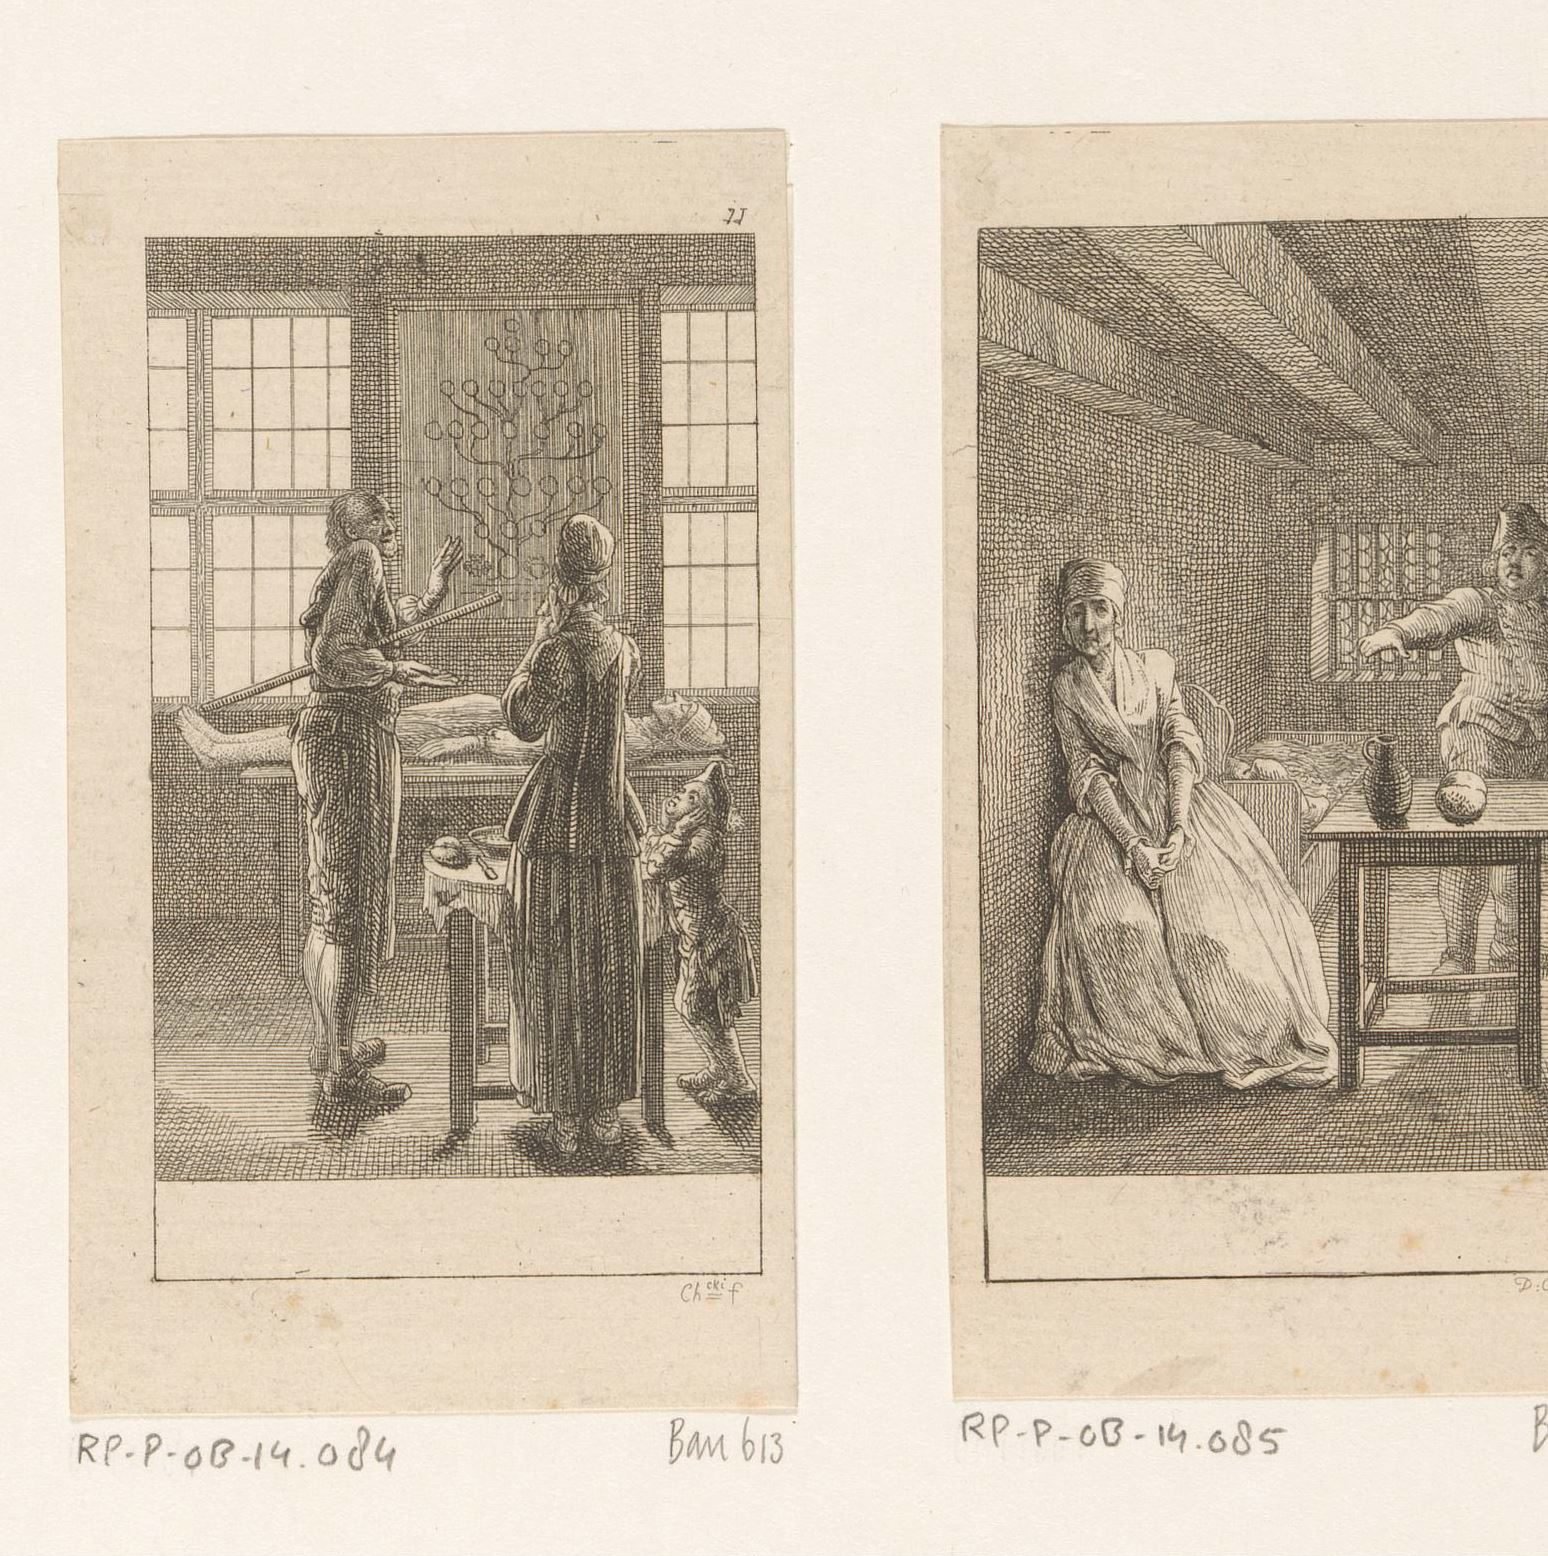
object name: print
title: Verloren krediet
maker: daniel nikolaus chodowiecki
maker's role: draughtsman, print maker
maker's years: 1726-1801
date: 1779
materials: paper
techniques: etching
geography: berlin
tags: conversation, dialogue; conversation piece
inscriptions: collector's mark: Lugt 2228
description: Elfde prent uit een serie van twaalf scènes uit het leven van een slecht opgevoede vrouw. Deze voorstellingen werden samen op een plaat geëtst. De beschrijvingen zijn gebaseerd op 'Kokettenspiegel. Ein deutsches Sittengemälde nach zwölf Blättern von Daniel Chodowiecki', gepubliceerd in 'Die graue Mappe' (1791). Een latere staat van deze serie is ook gebruikt in: Berliner Genealogischen Calender auf das Schaltjahr 1780.